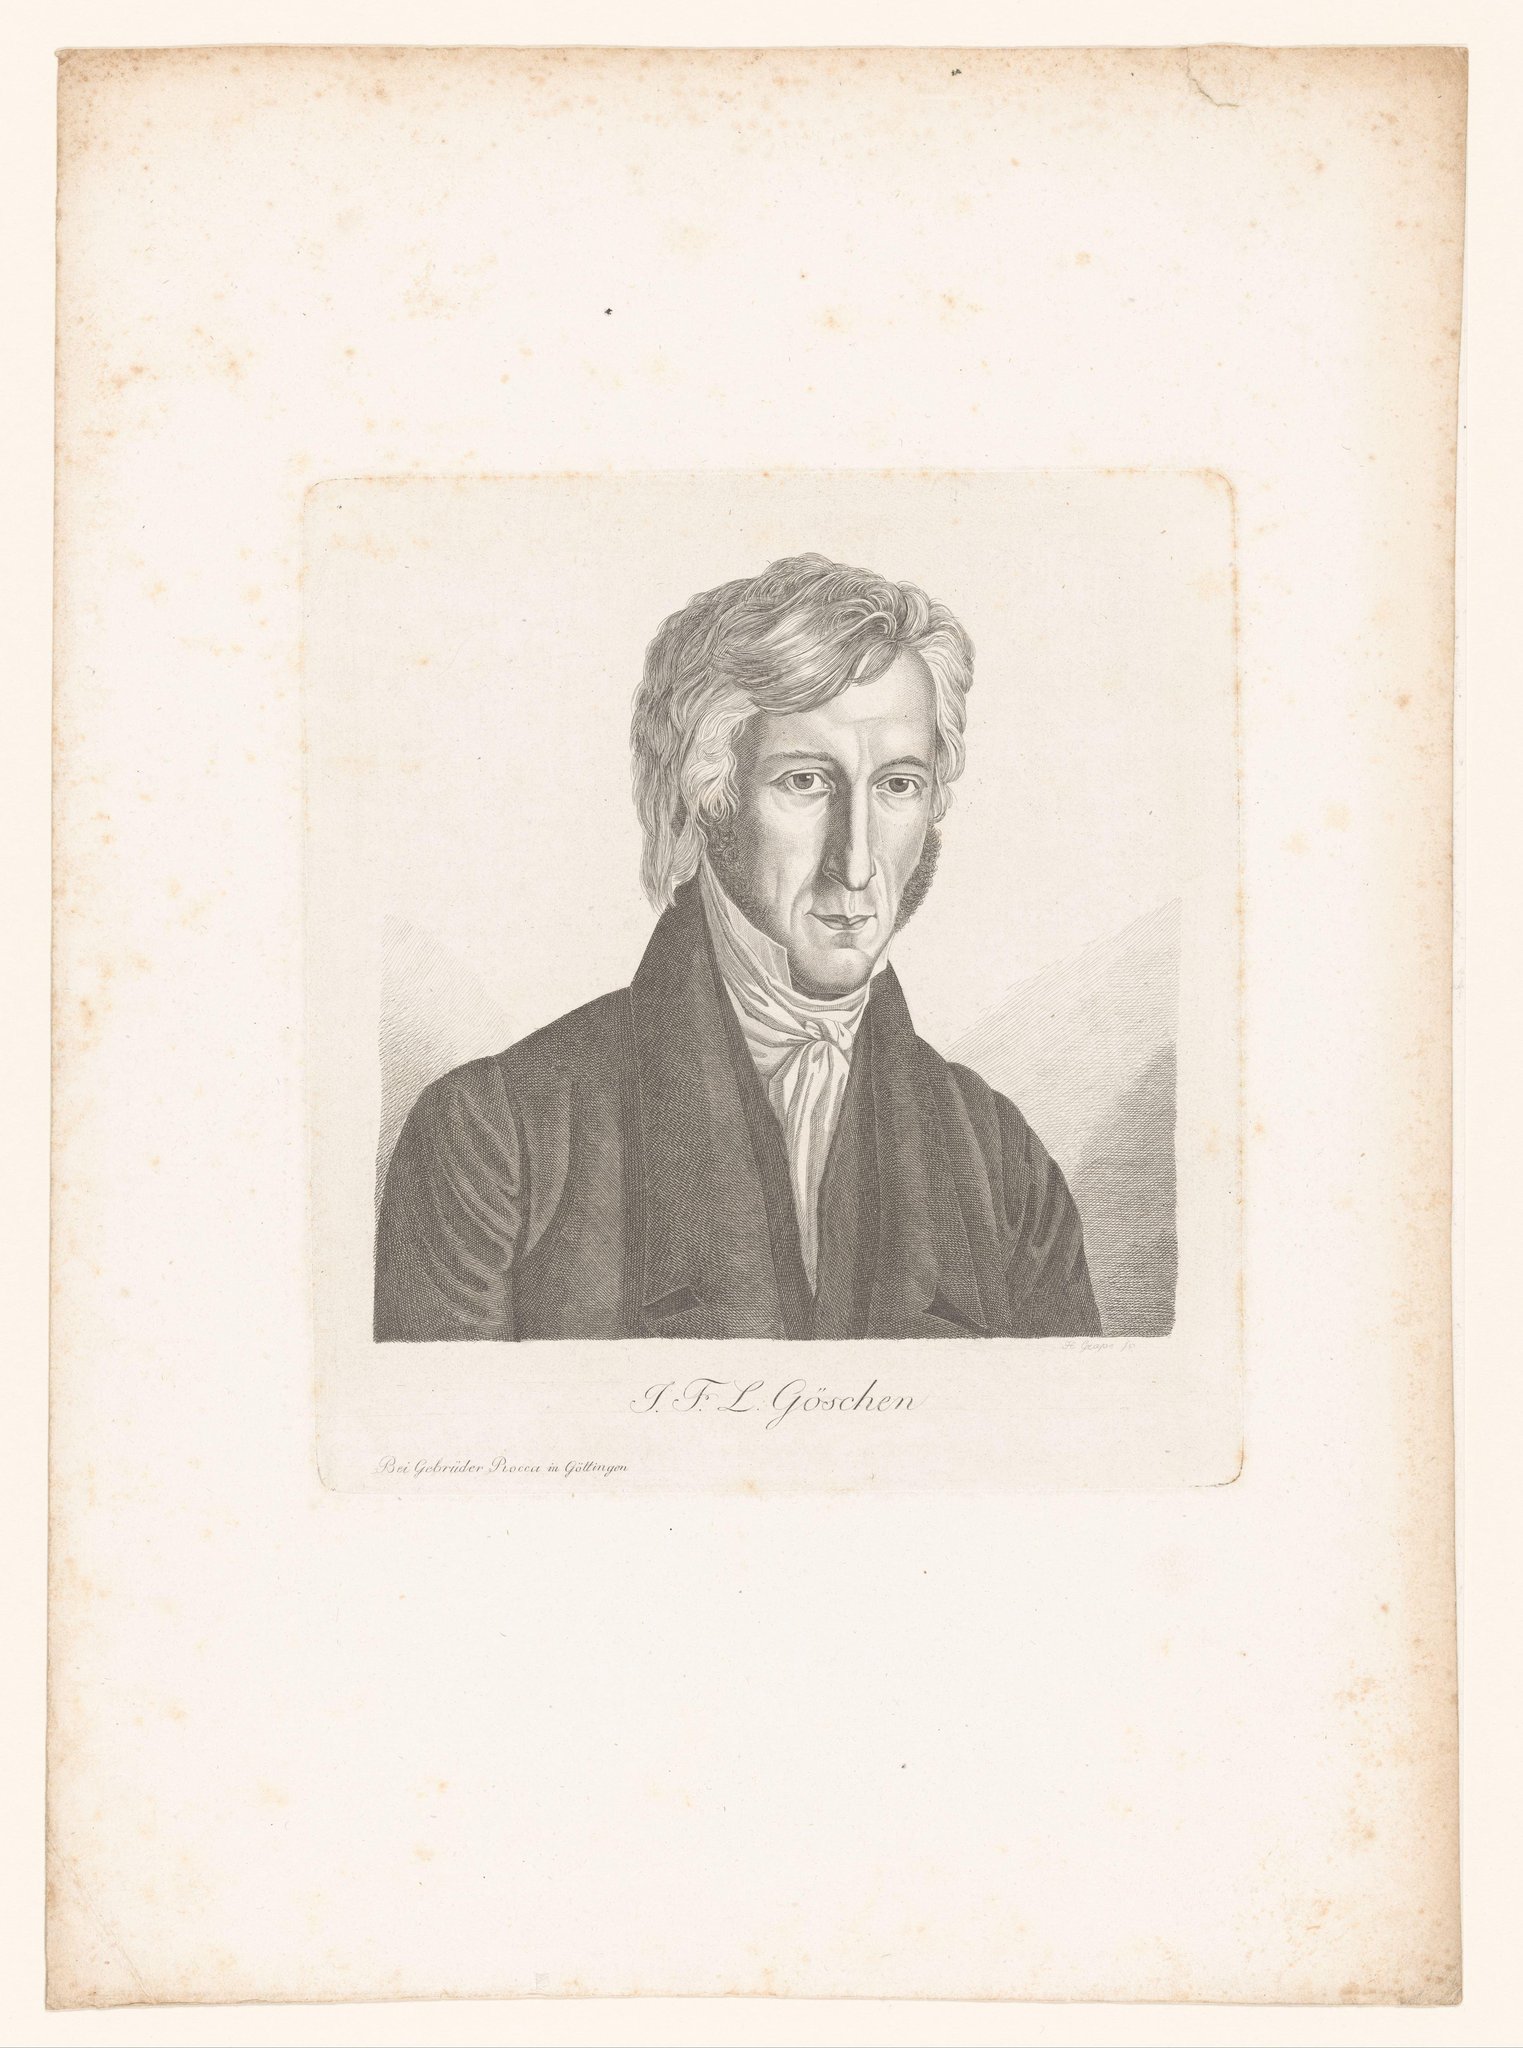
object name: print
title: Portret van Johann Friedrich Ludwig Göschen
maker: heinrich martin grape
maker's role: print maker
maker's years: 1798-1875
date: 1788-1834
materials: paper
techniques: engraving, etching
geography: gottingen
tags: historical persons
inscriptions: collector's mark: Lugt 2228